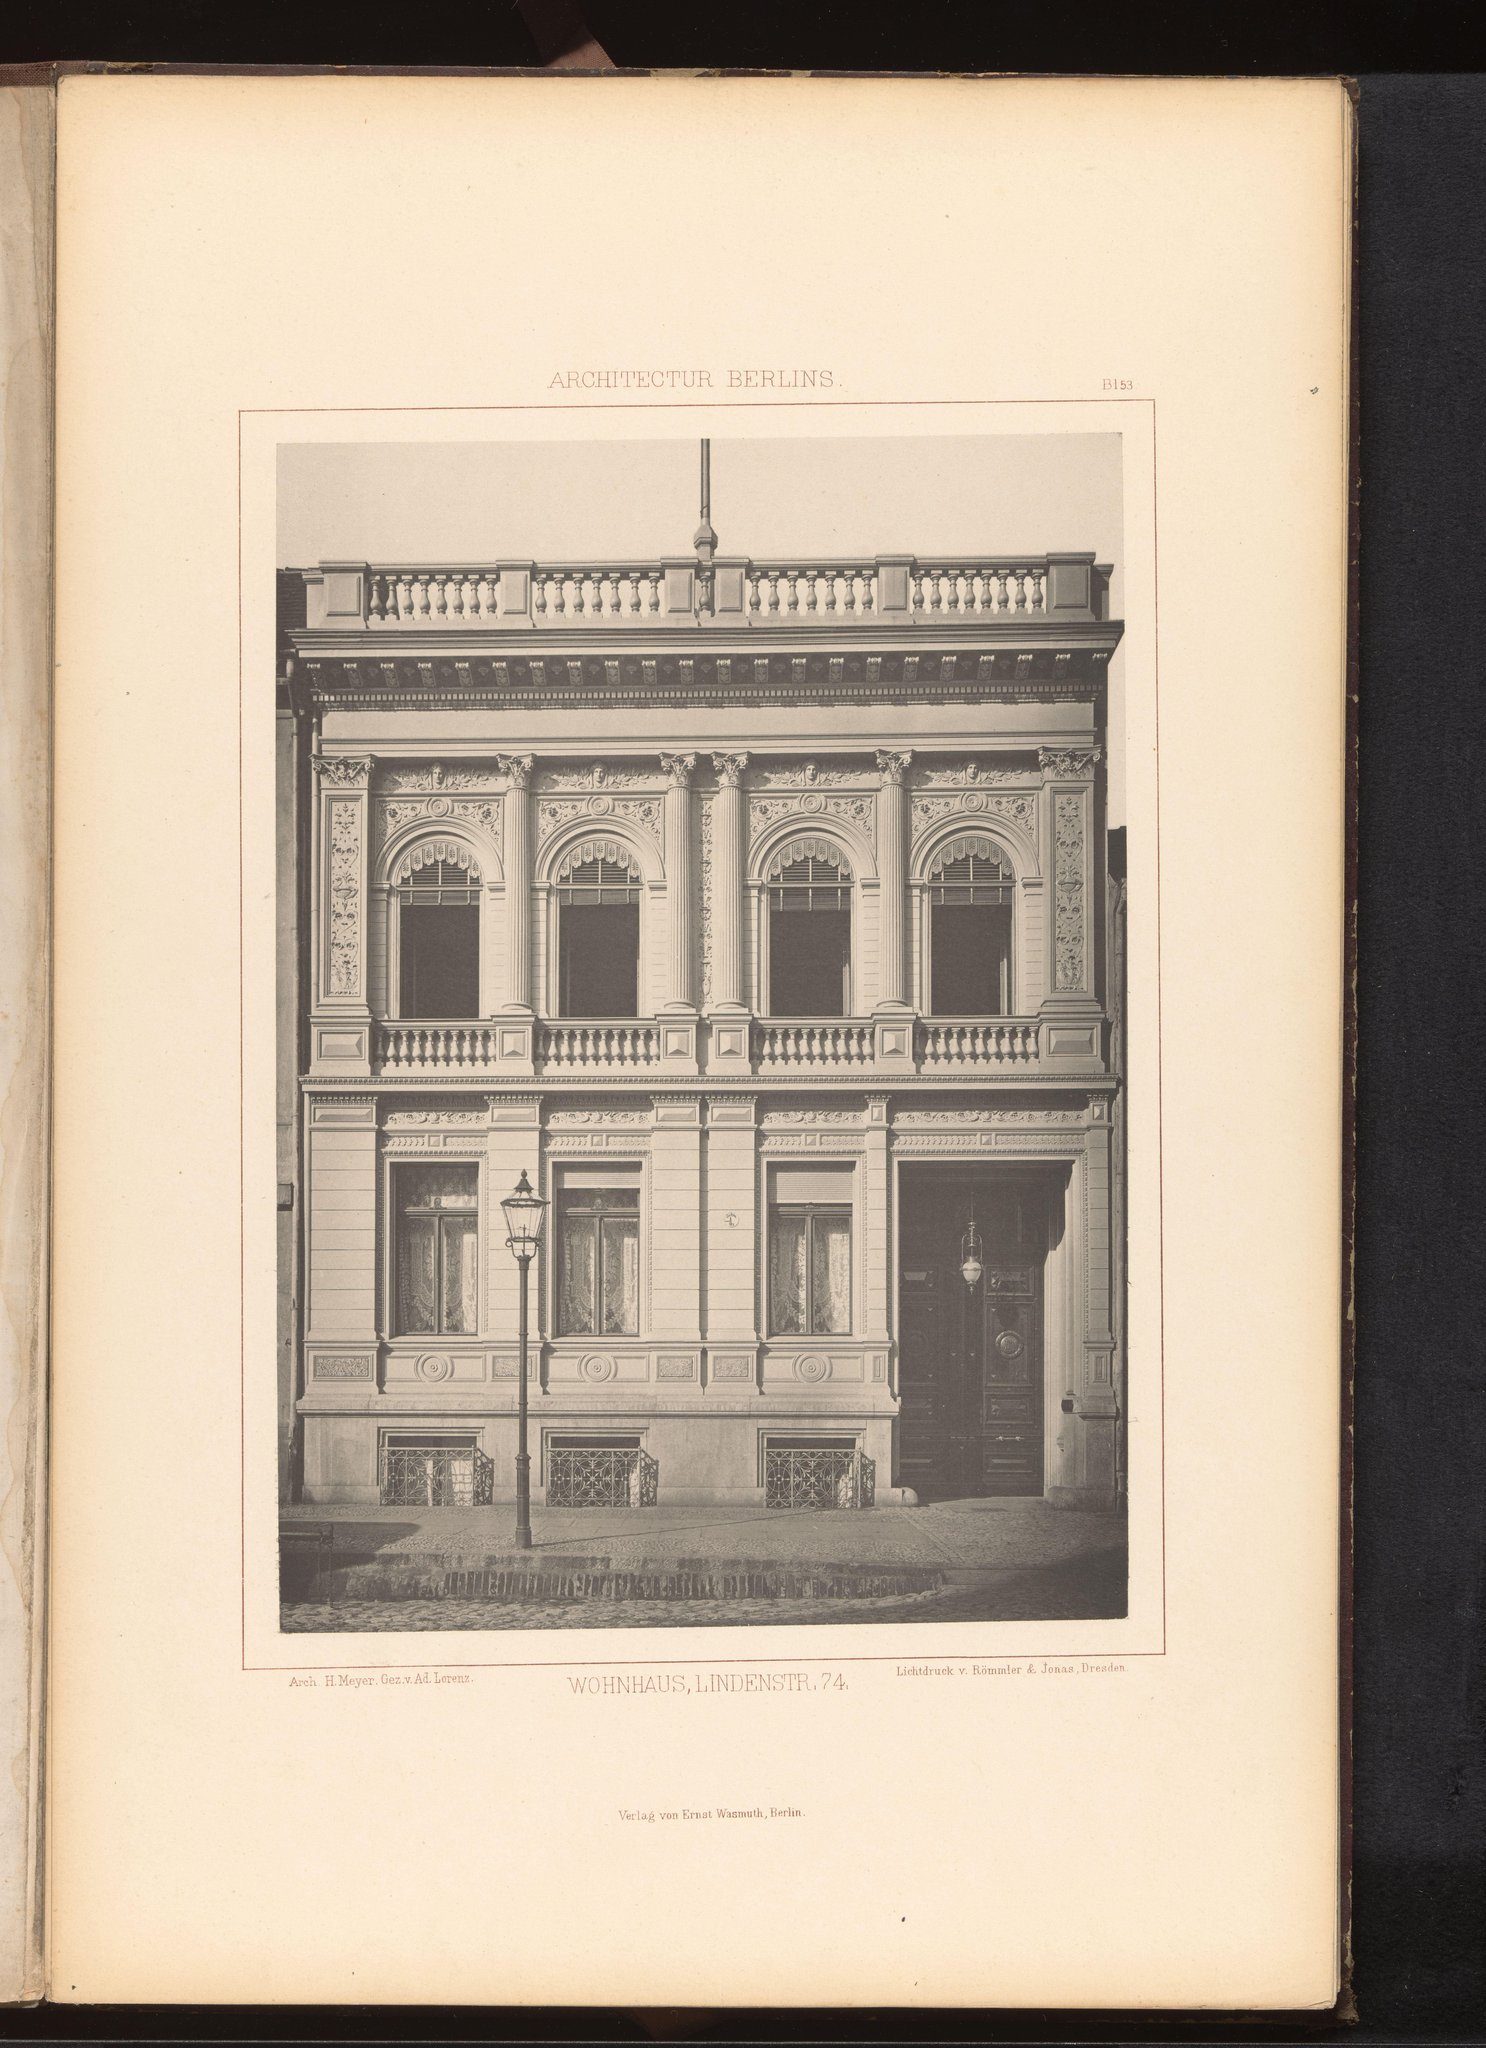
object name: photomechanical print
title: Wohnhaus, Lindenstr. 74.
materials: paper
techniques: photograph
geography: berlin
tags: detached house in city, berlin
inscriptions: inscription: ‘Arch. H. Meyer. Gez. v. Ad. Lorenz.’, number: ‘Bl. 53.’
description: Deze prent maakt deel uit van een omslag met honderd prenten en zes tekstbladen.